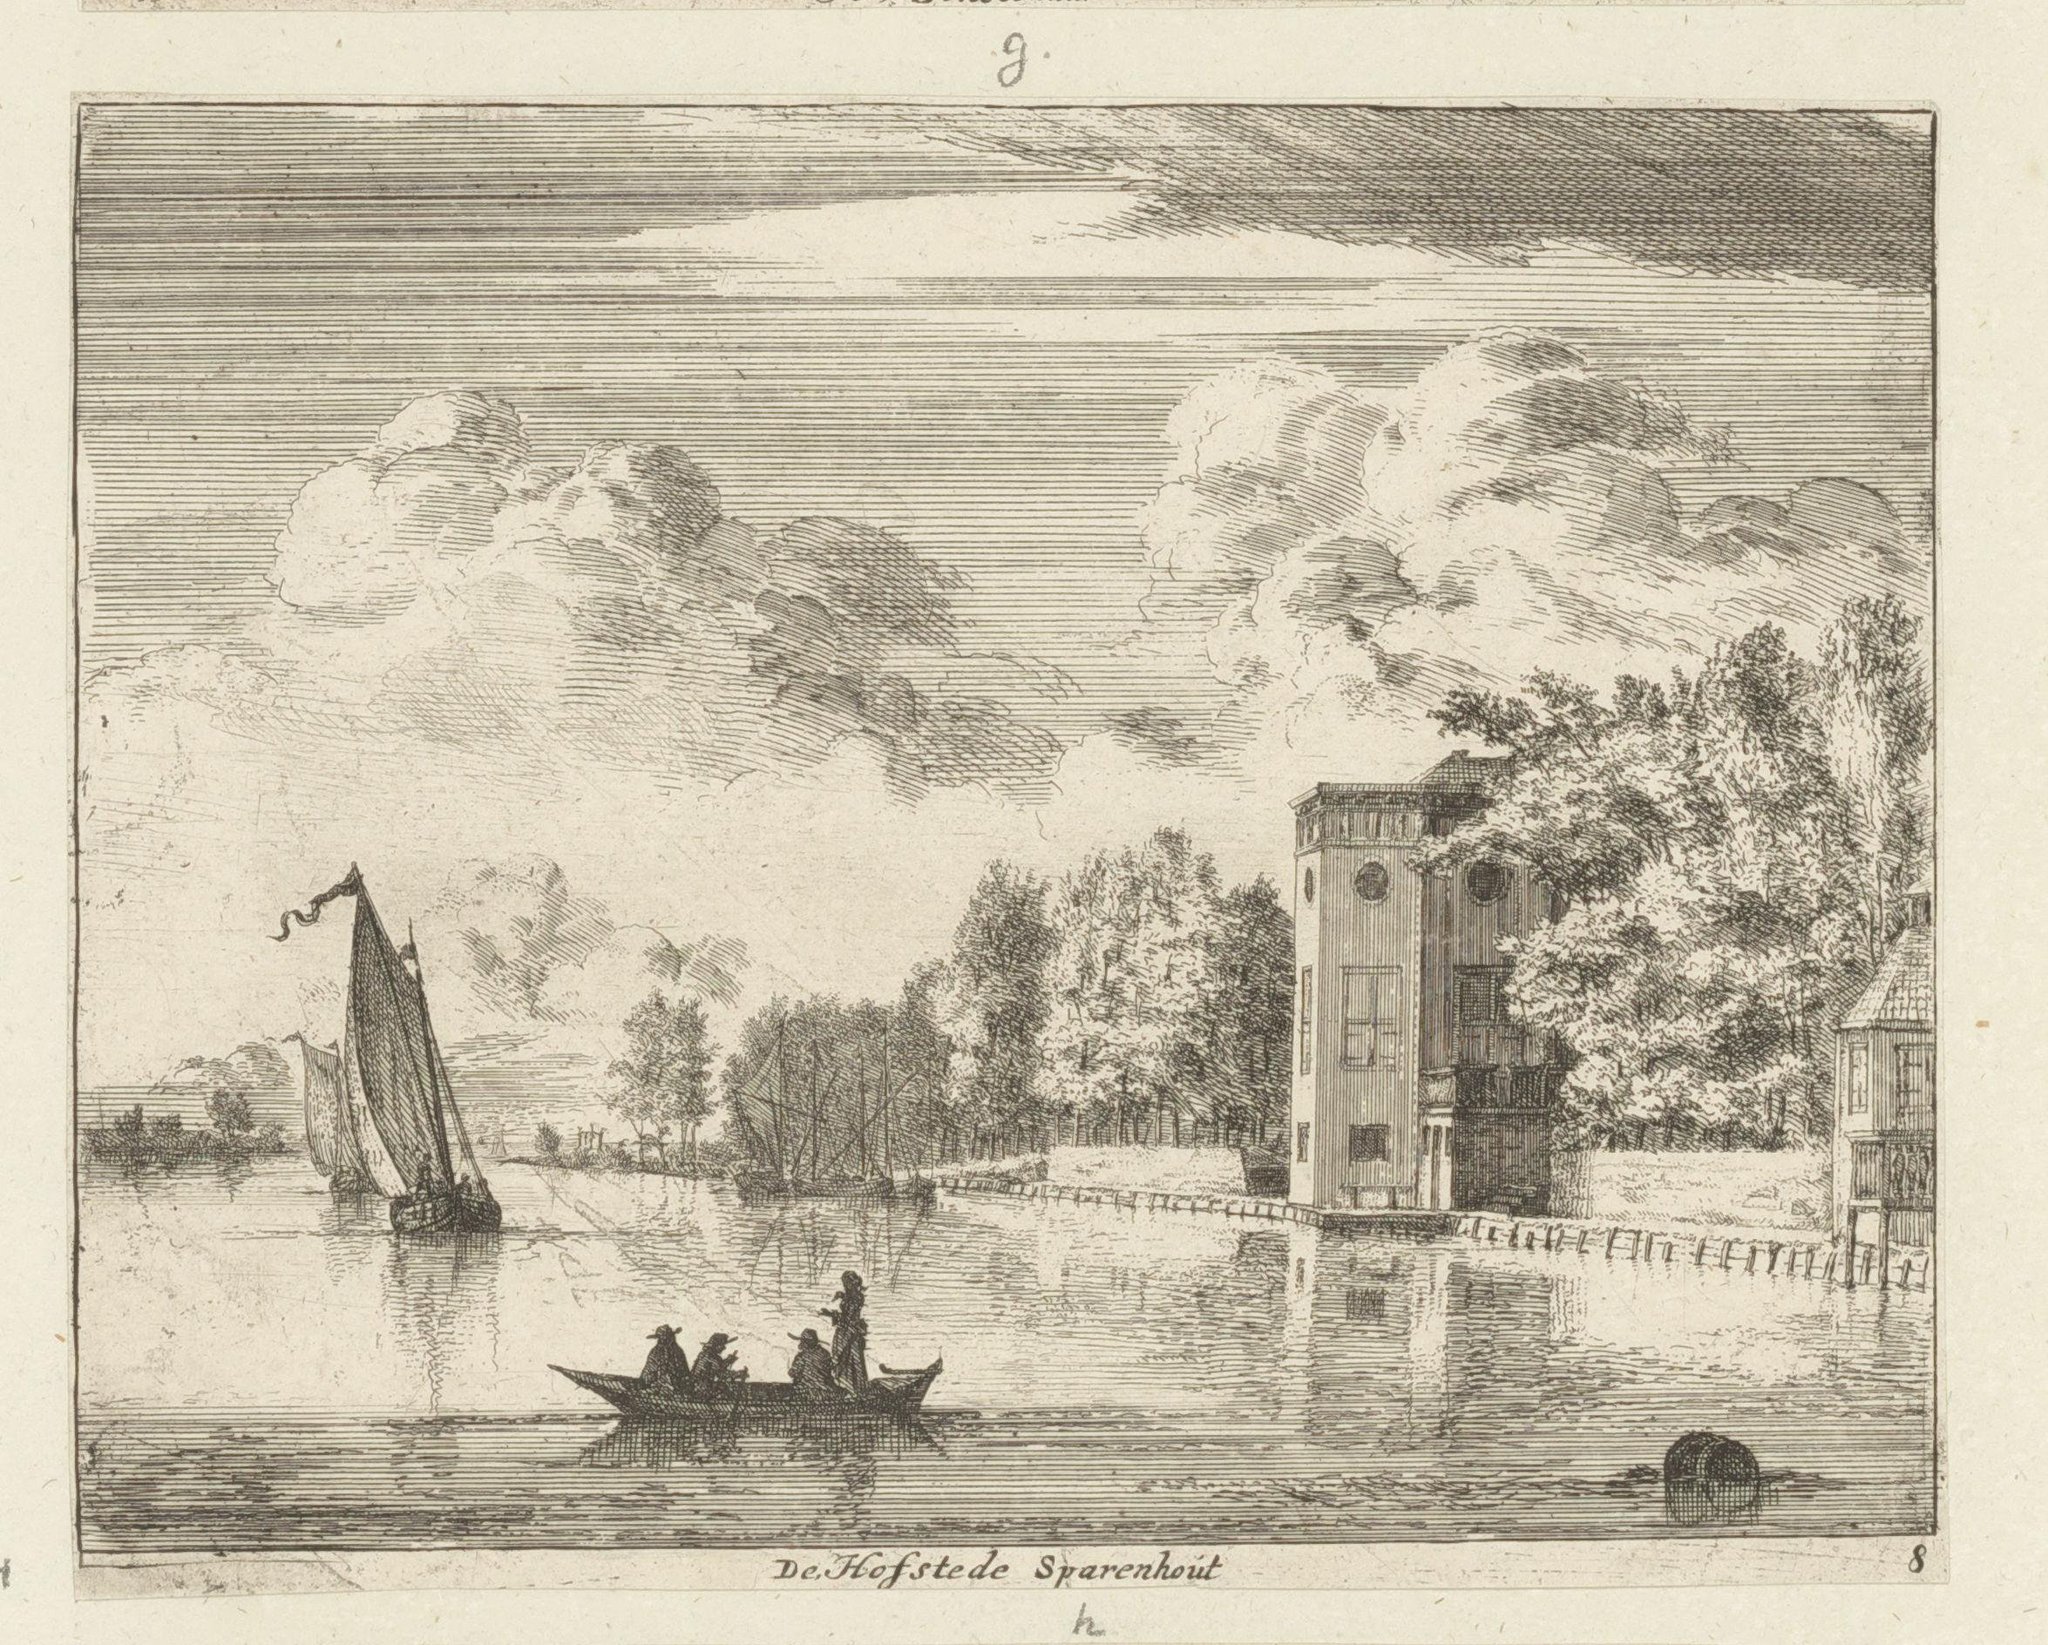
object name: print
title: Gezicht op Hofstede Sparenhout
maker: jan vincentsz. van der vinne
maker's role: draughtsman, print maker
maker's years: 1663-1721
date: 1688-1690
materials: paper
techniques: engraving, etching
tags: sailing-ship, sailing-boat, landscapes (+ landscape with figures, staffage), outskirts of village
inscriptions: collector's mark: Lugt 1641, stamp, stamp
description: Gezicht op de hofstede Sparenhout te Haarlem. Op het water twee zeilschepen en een roeiboot met vier figuren. Rechtsonder genummerd: 8. Onderwerpsrubrieken binnen de Atlas Zeden en Gewoonten: Handel, nijverheid en verkeer, Buitenleven.